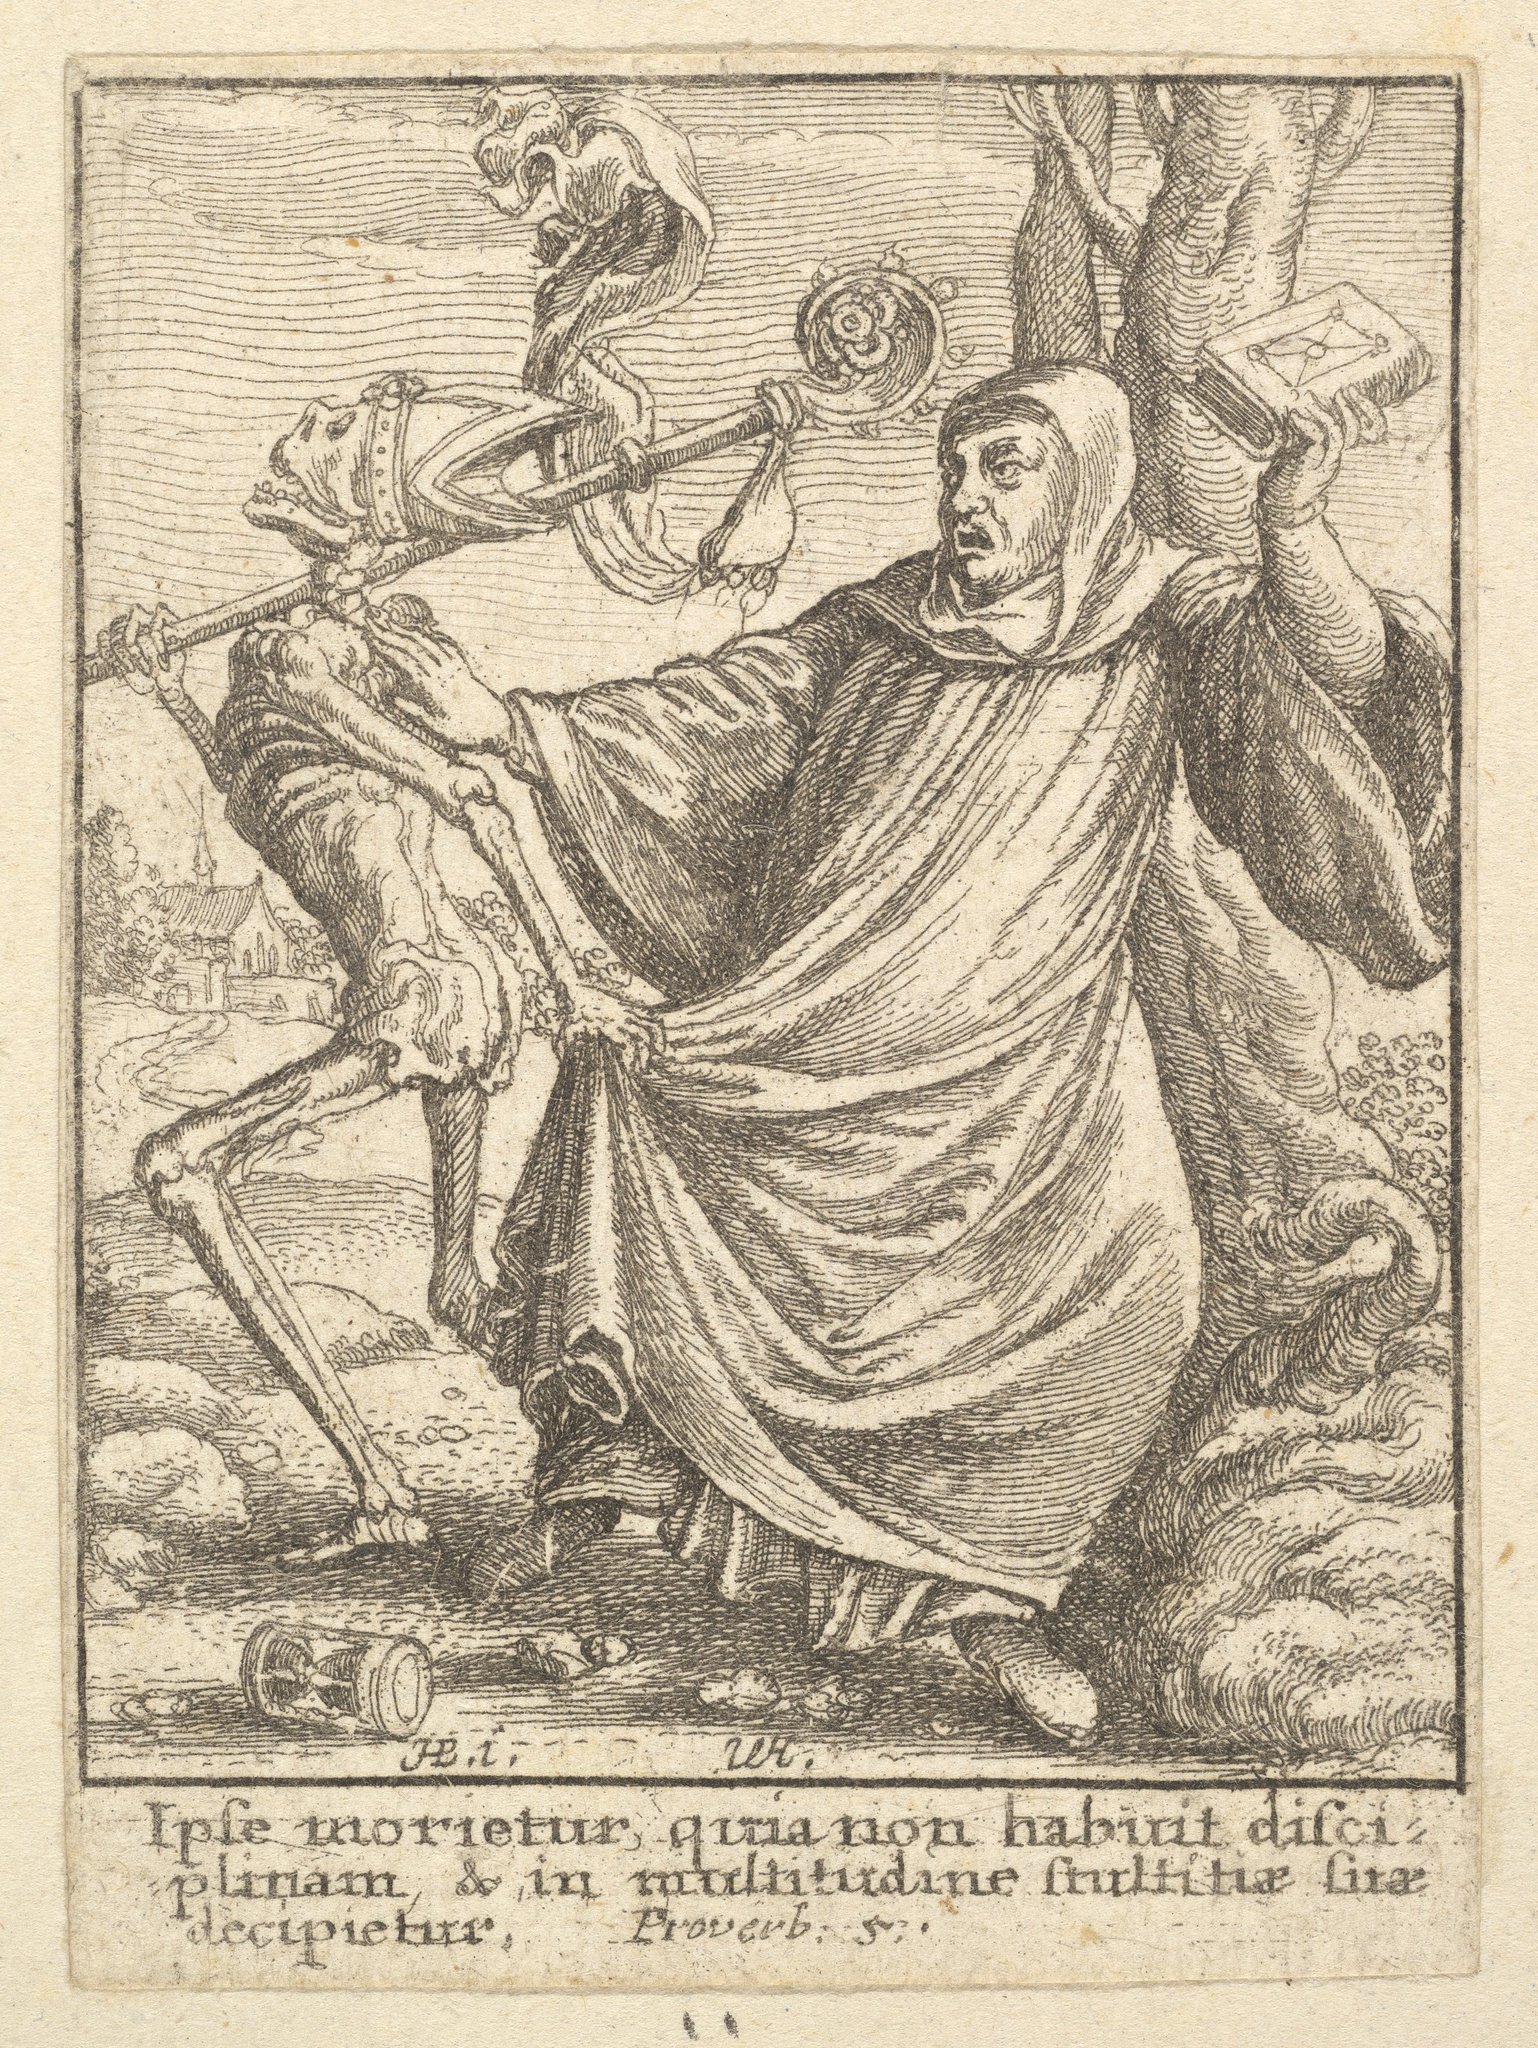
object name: print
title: Abbot, from the Dance of Death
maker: wenceslaus hollar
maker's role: artist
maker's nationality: bohemian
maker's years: 1607-1677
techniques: etching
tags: skeletons,men